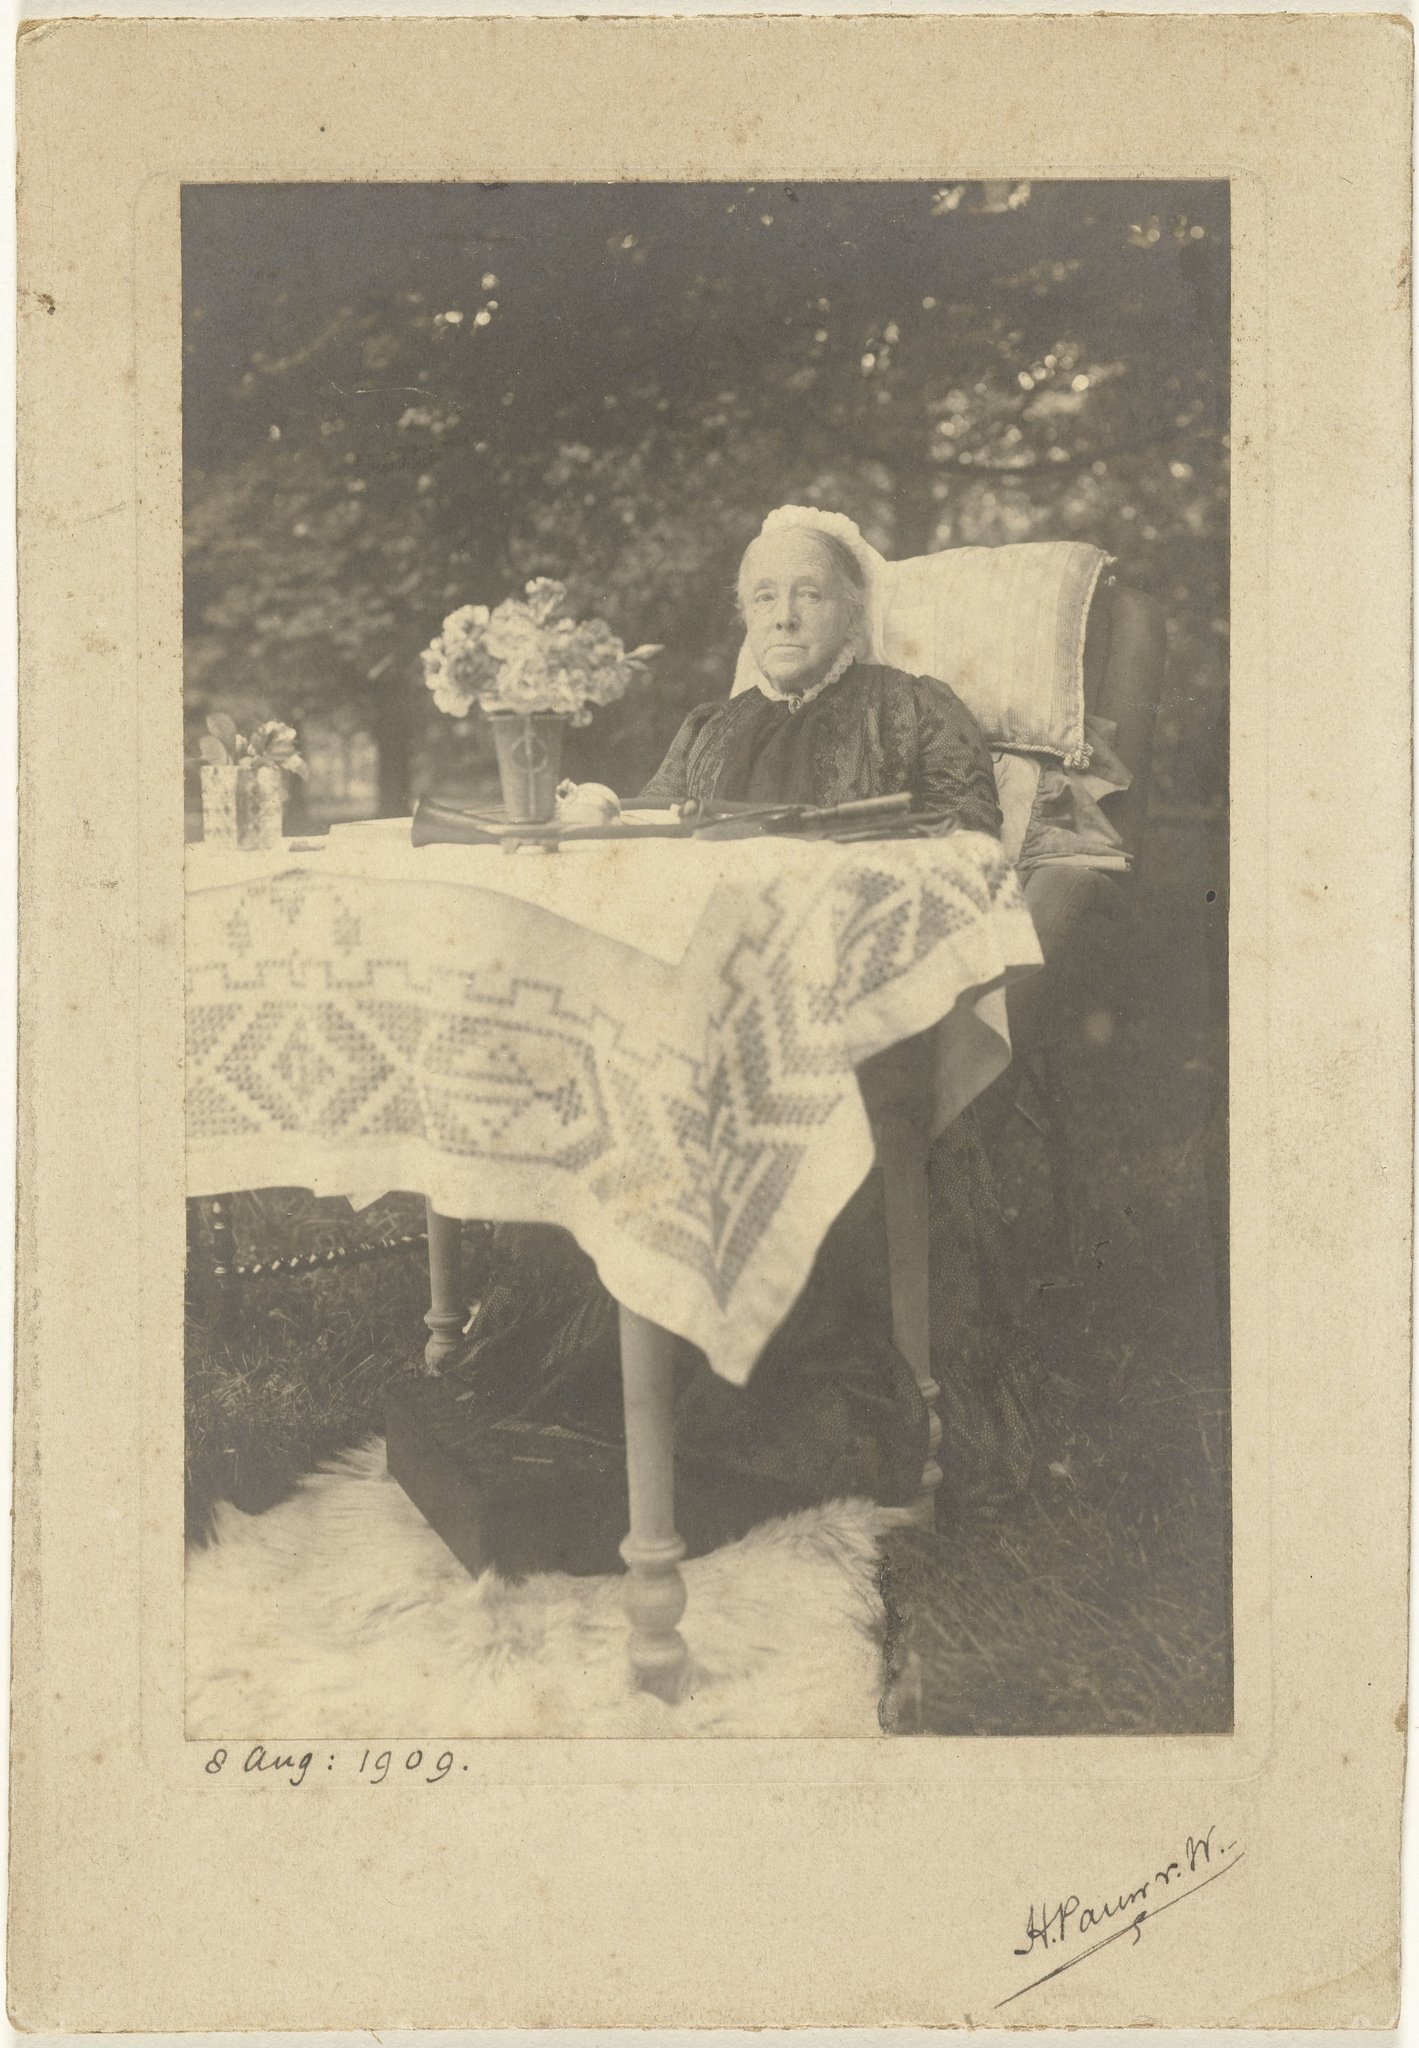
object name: photograph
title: Portret van Aletta Cornelia Anna Voombergh (1828-1913), de moeder van de fotograaf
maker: henry pauw van wieldrecht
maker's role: fotograaf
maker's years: 1863-1912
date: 1909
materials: cardboard, photographic support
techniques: albumen print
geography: netherlands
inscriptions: signature and date: ‘8 Aug; 1909. / H. Pauw v. W.’, annotation: ‘Granny Pauw’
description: Mevrouw Voombergh is de moeder van Henry Pauw van Wieldrecht